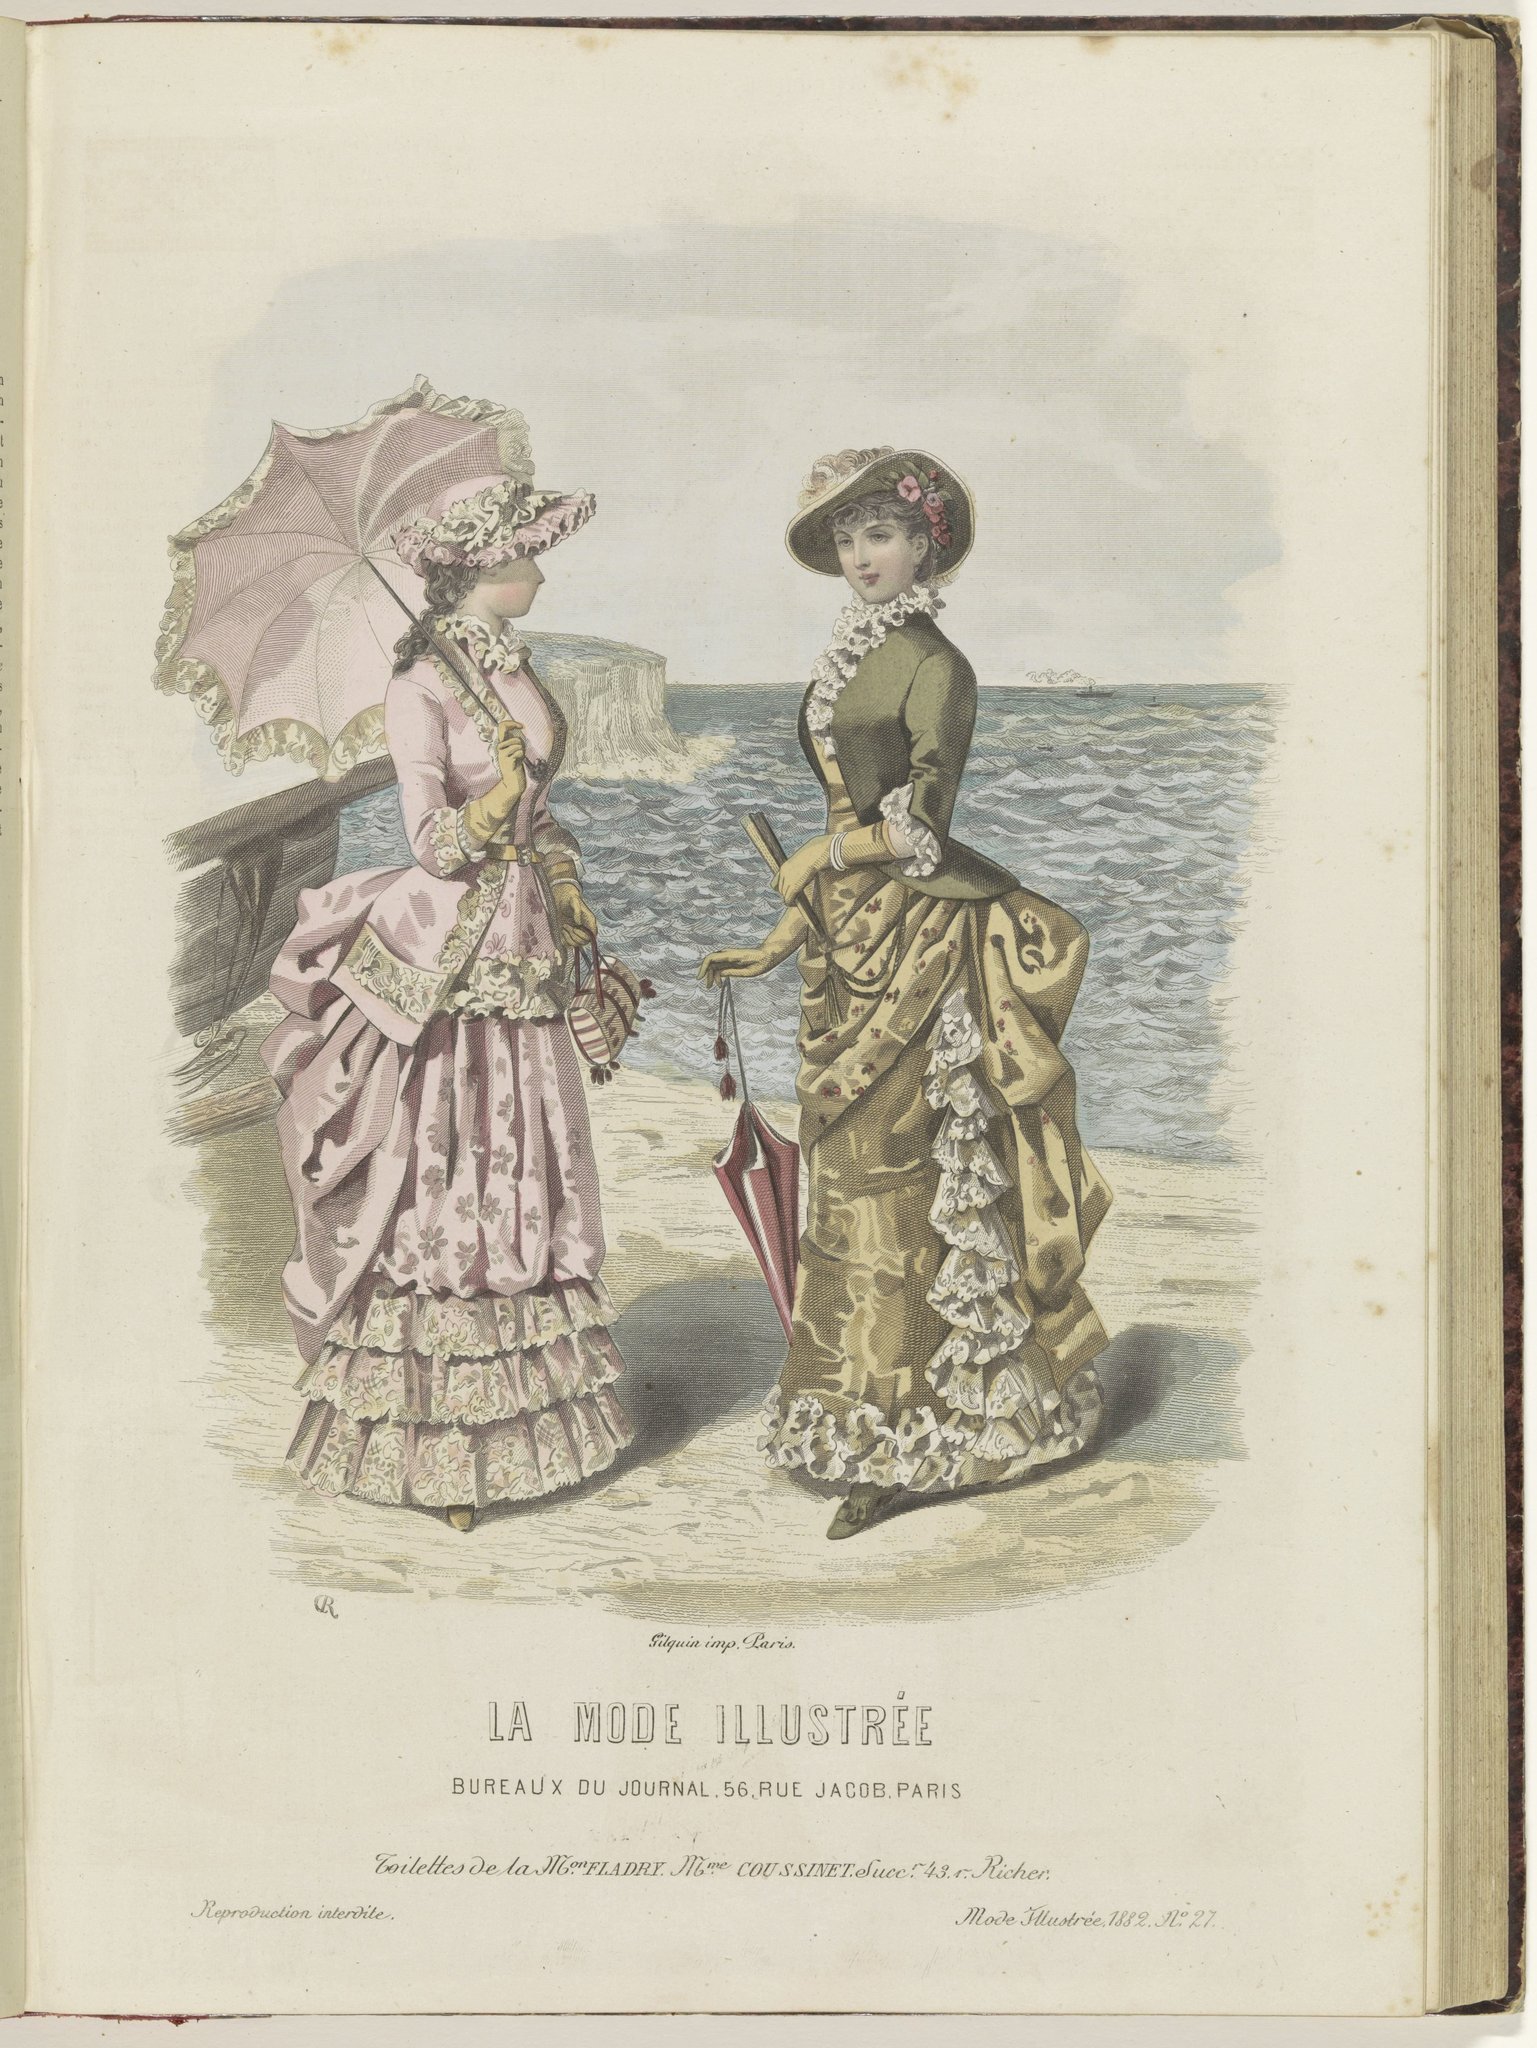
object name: magazine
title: La Mode Illustrée, Journal de la Famille, 1882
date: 1882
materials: paper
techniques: engraving, hand coloring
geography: paris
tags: fashion plates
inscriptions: date